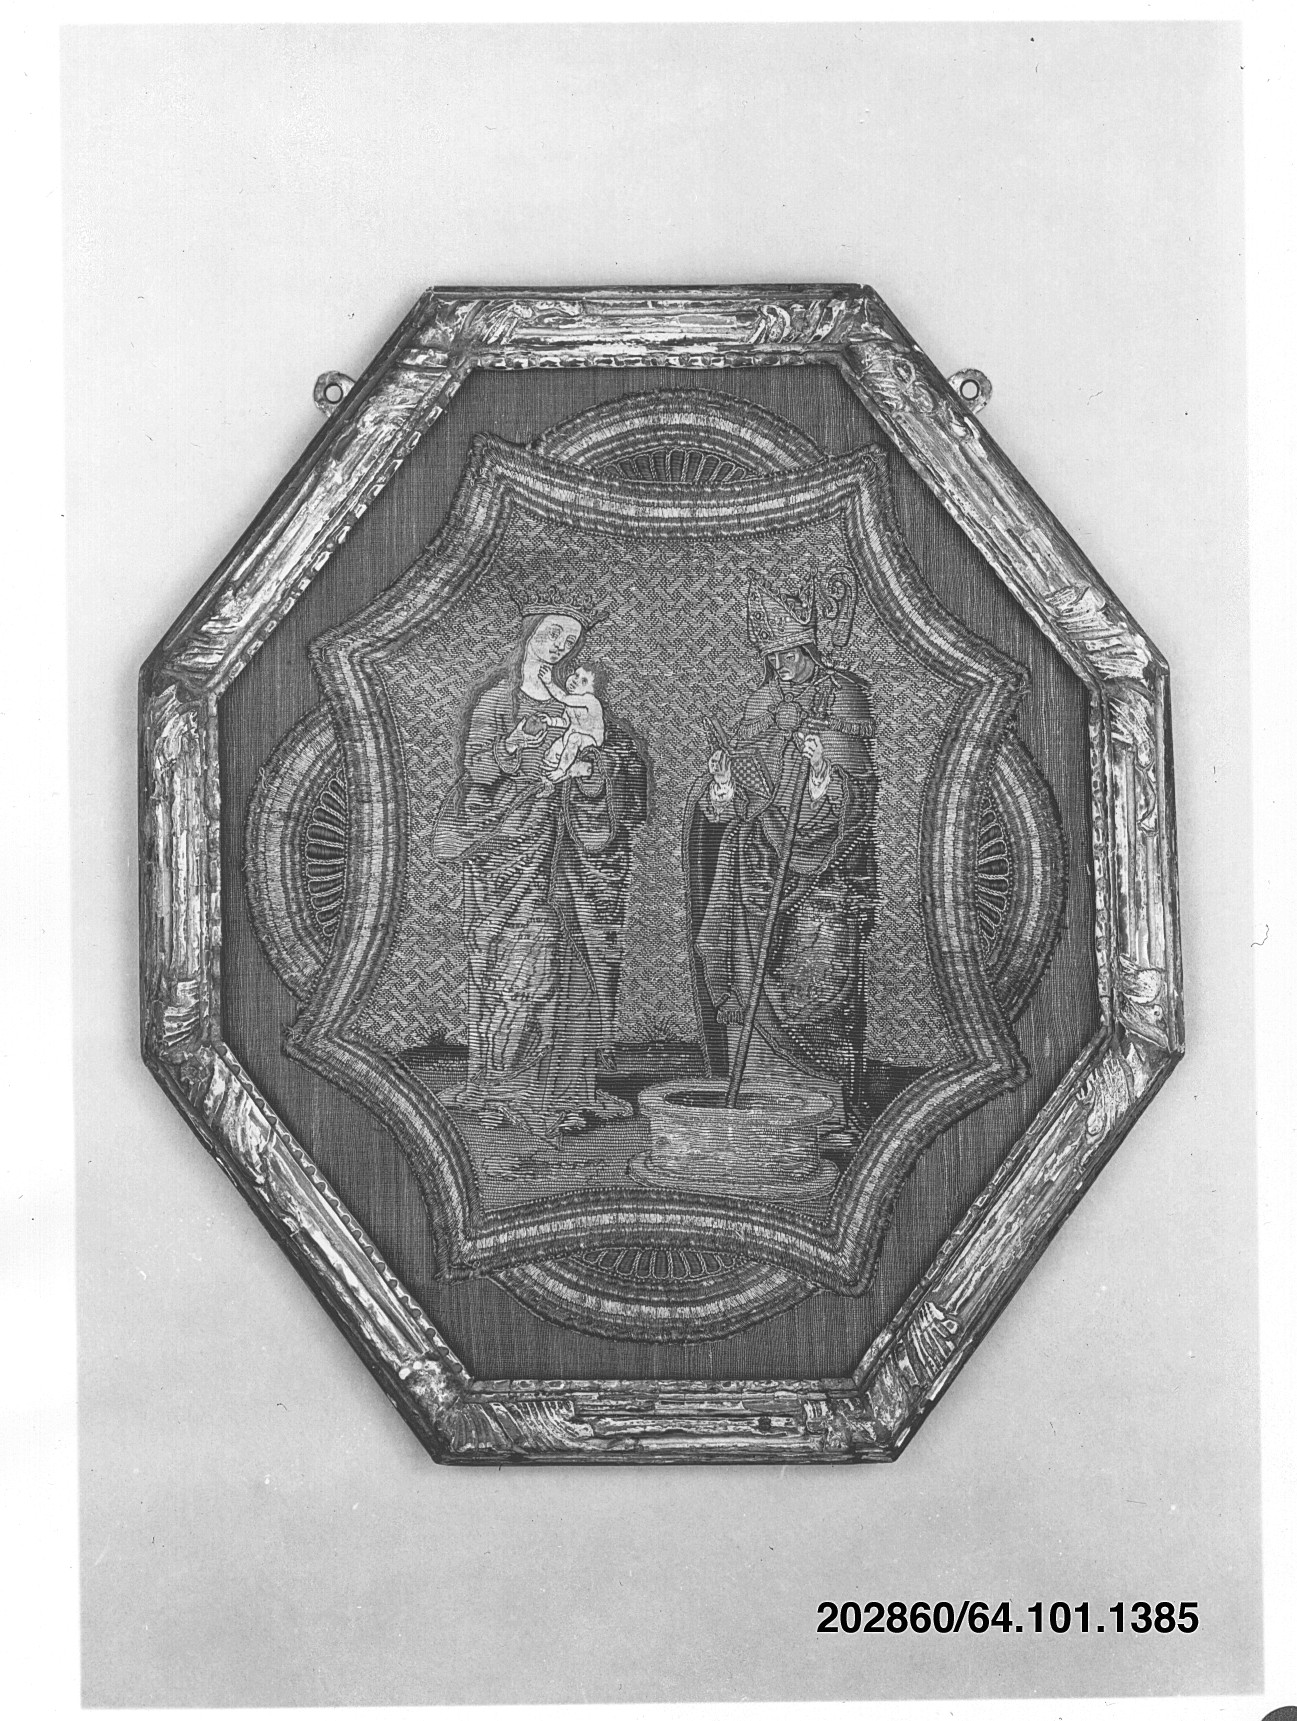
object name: orphrey fragment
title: Appliqué from an orphrey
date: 1501-1600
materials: canvas, metal thread, silk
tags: madonna and child